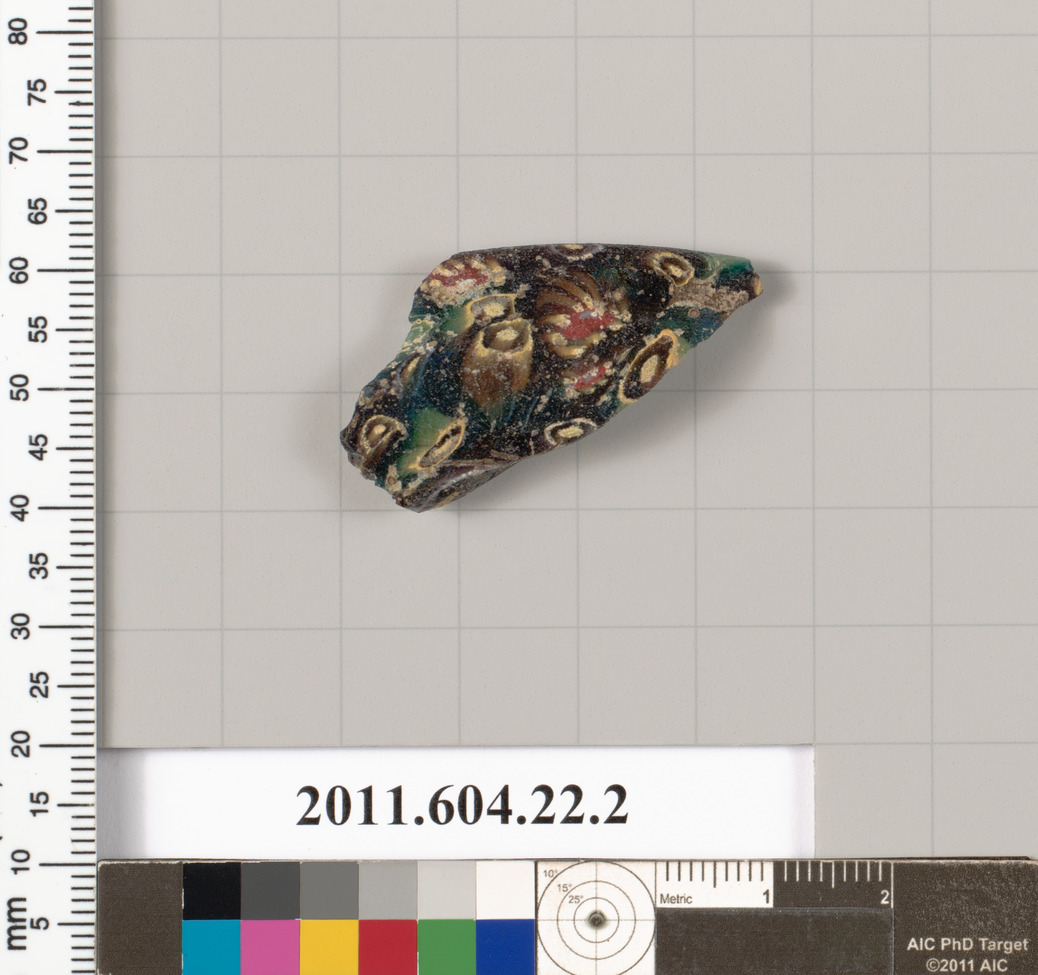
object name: fragment, mosaic bowl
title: Glass mosaic bowl rim fragment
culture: roman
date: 34 BCE-33 CE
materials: glass